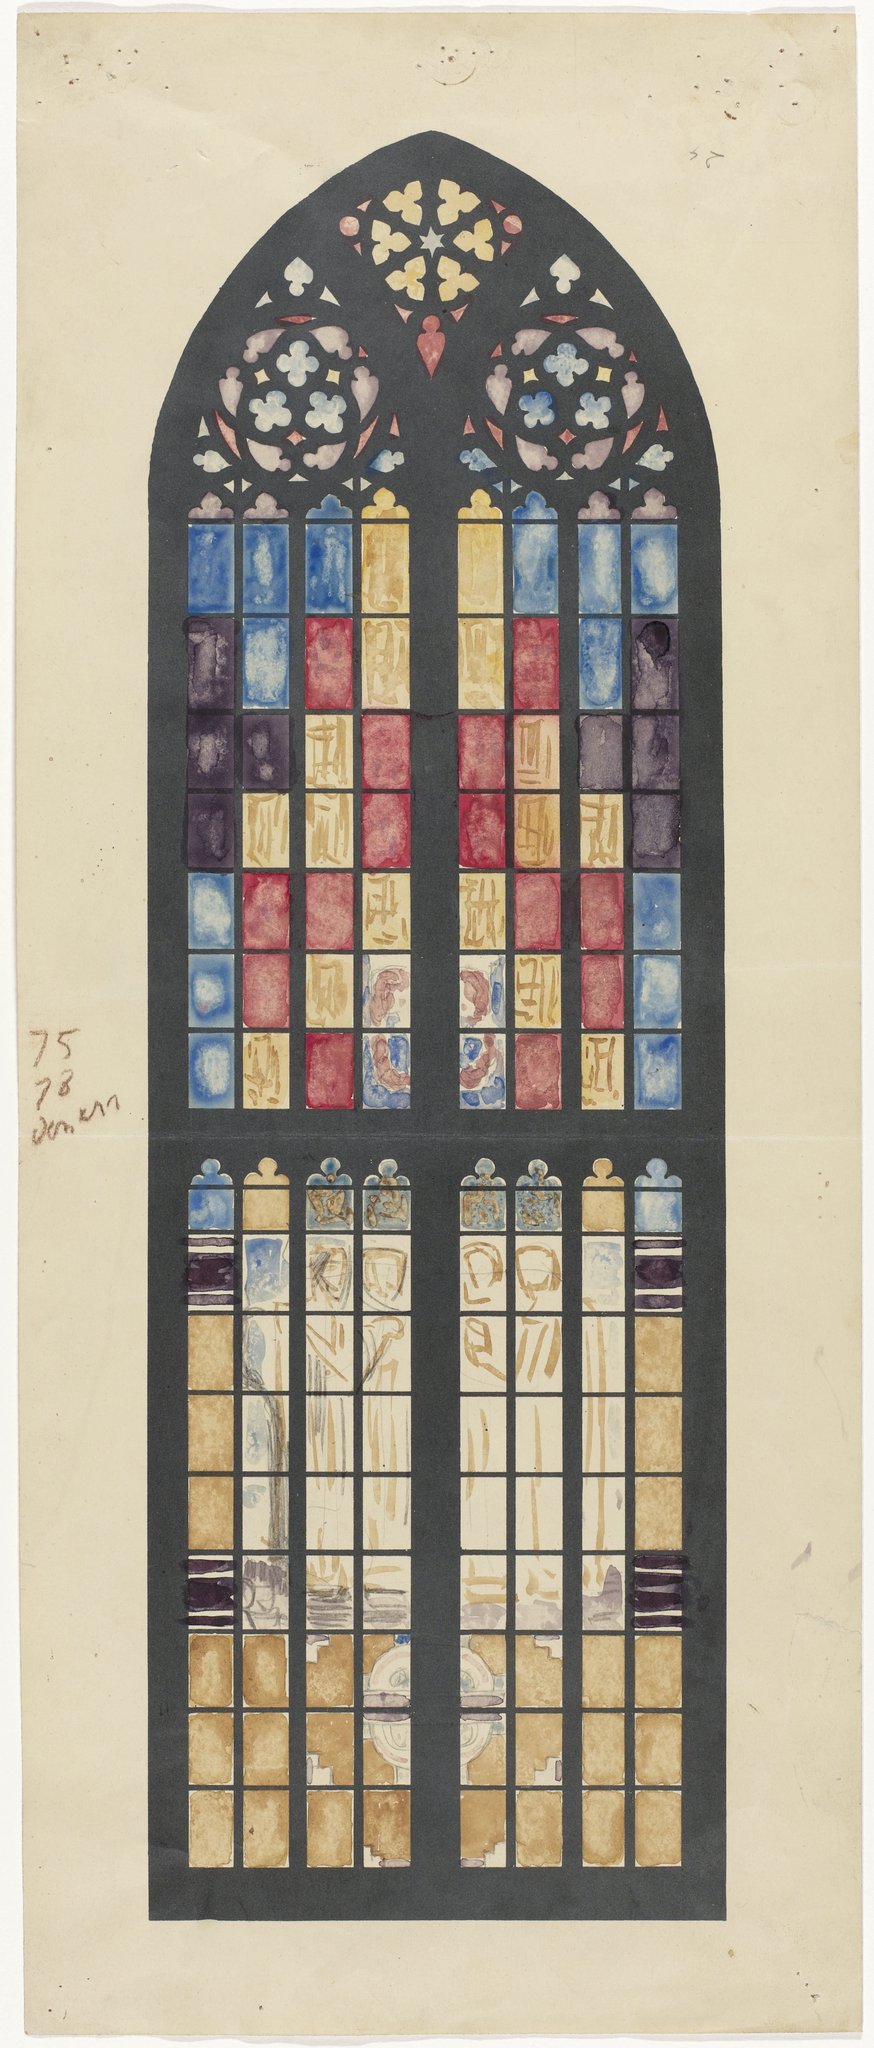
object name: watercolor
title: Ontwerp voor raam in het Zuidertransept van de Dom te Utrecht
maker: richard nicolaüs roland holst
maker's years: 1868-1938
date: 1878-1938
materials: paper, pencil, watercolor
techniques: brush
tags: church-window, e.g. rose-window, utrecht